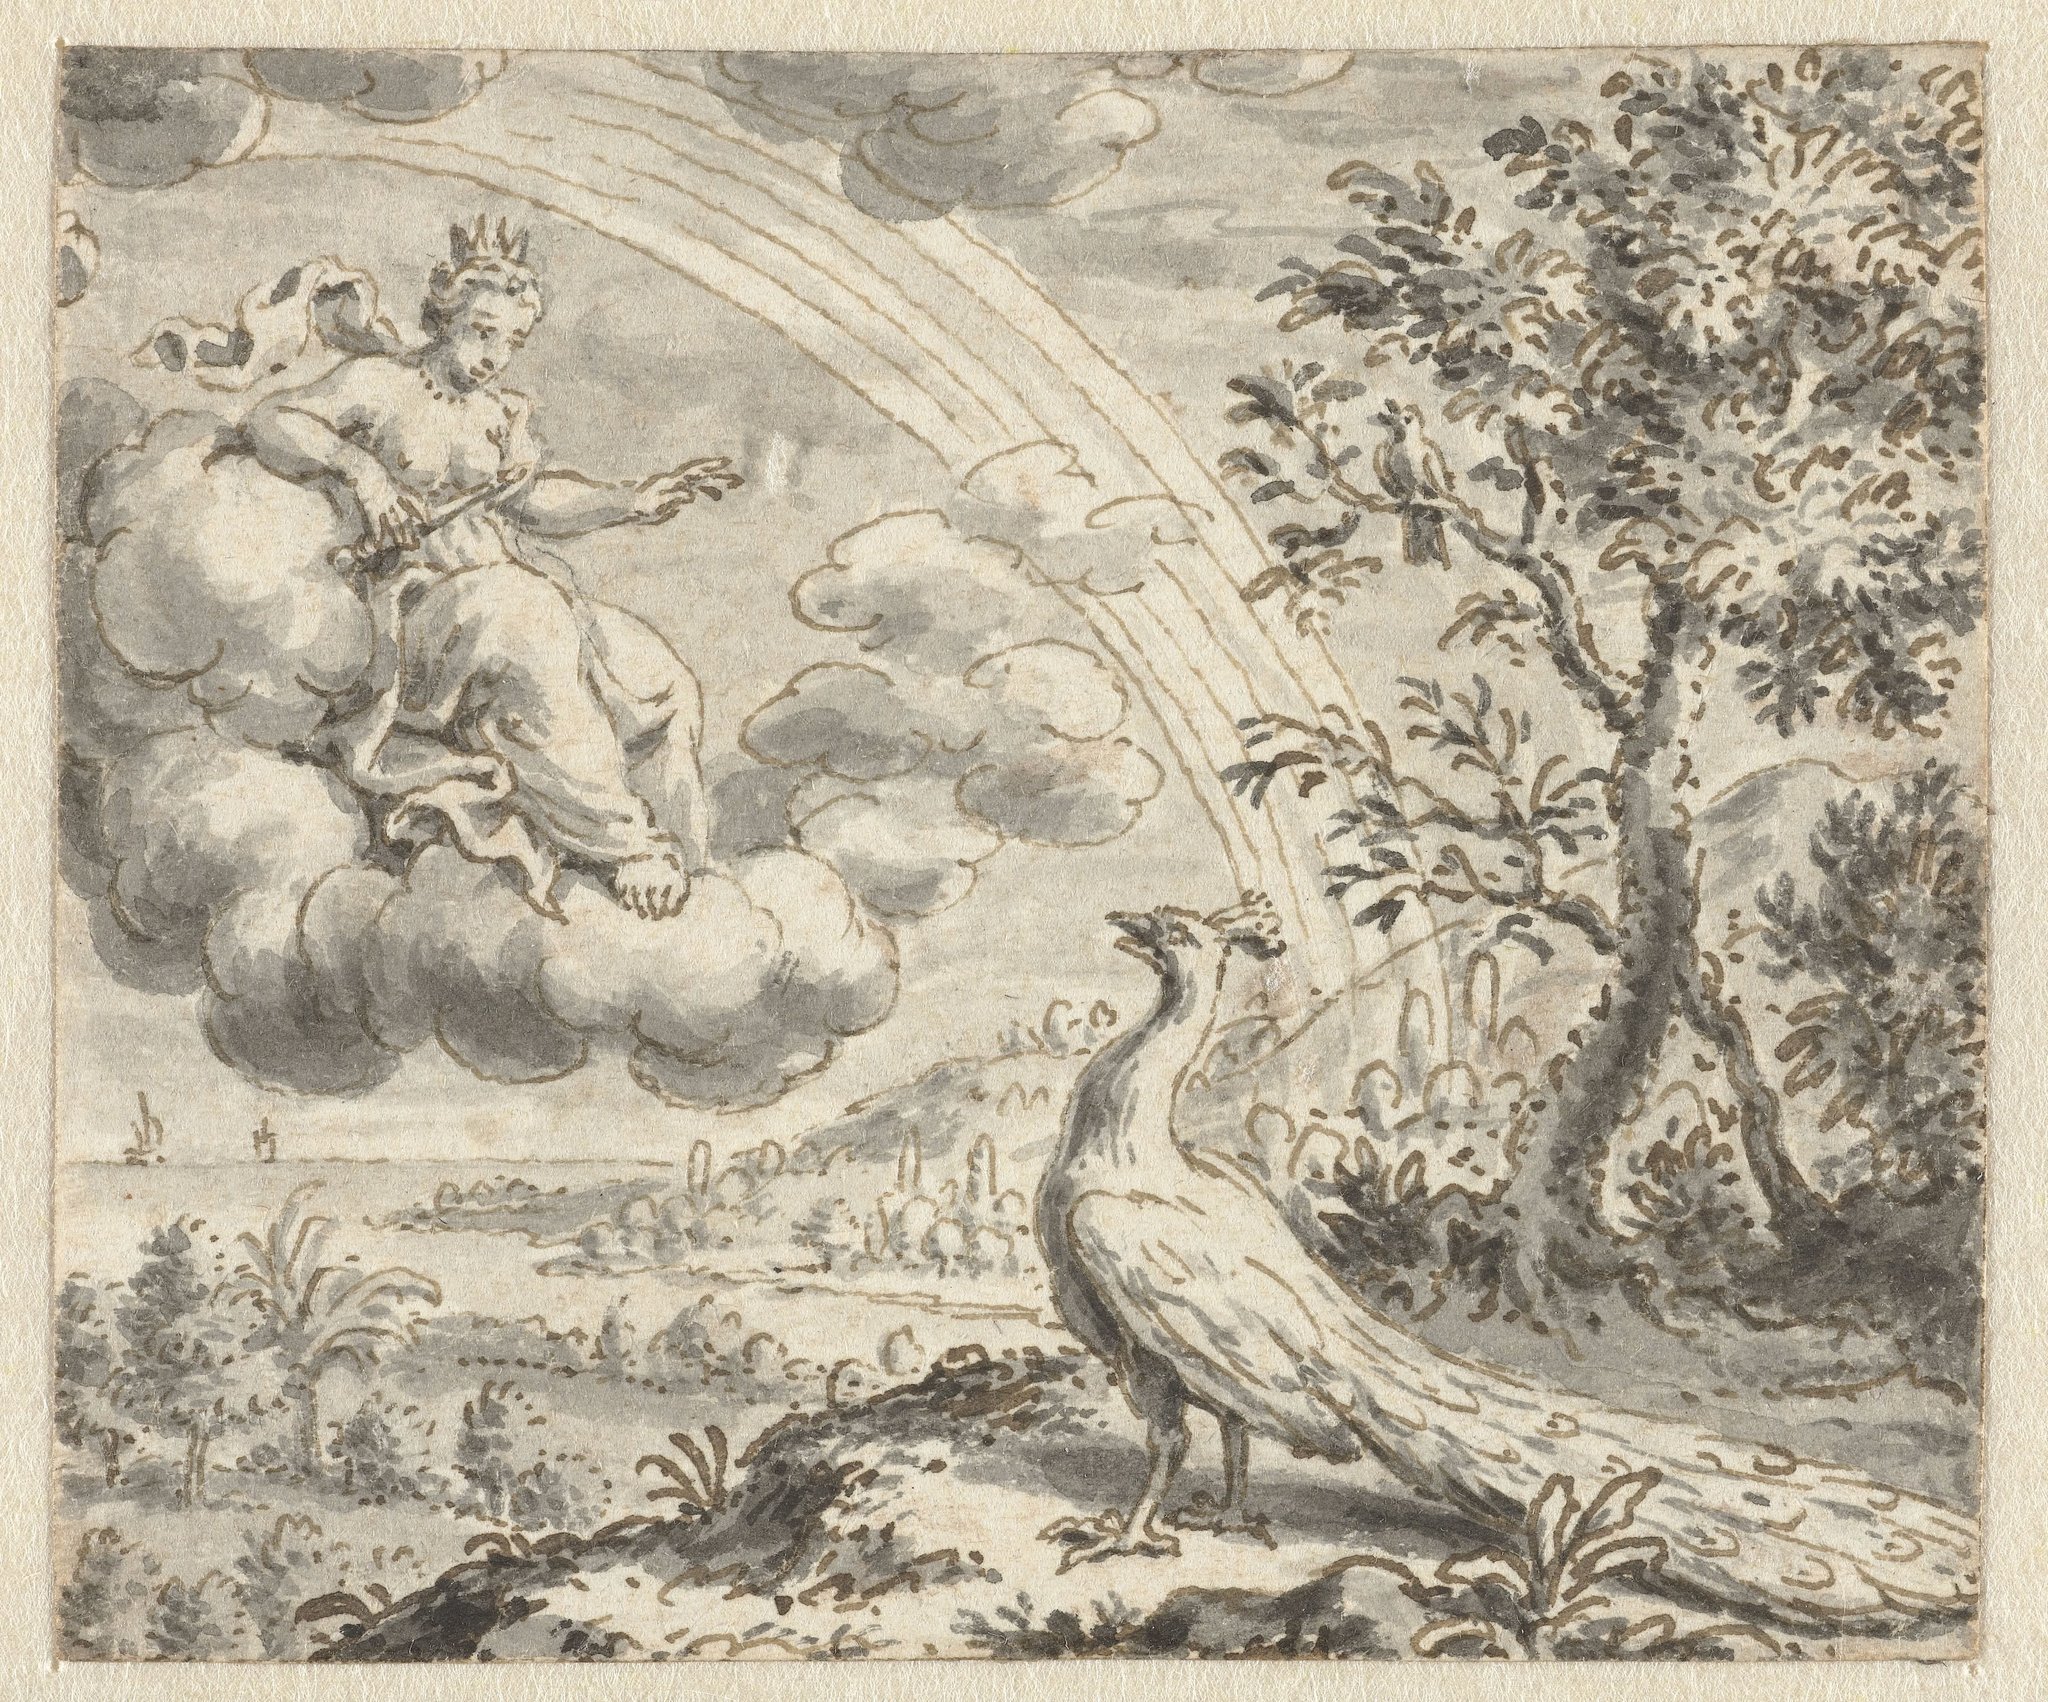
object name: design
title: Ontwerpen voor illustraties voor een uitgave van Jean de la Fontaine's Fabelen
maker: Anonymous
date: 1668-1740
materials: chalk, ink, paper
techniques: brush, pen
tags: (story of) juno (hera), ornamental birds: peacock, fables of lafontaine (with title) : use 85(...)